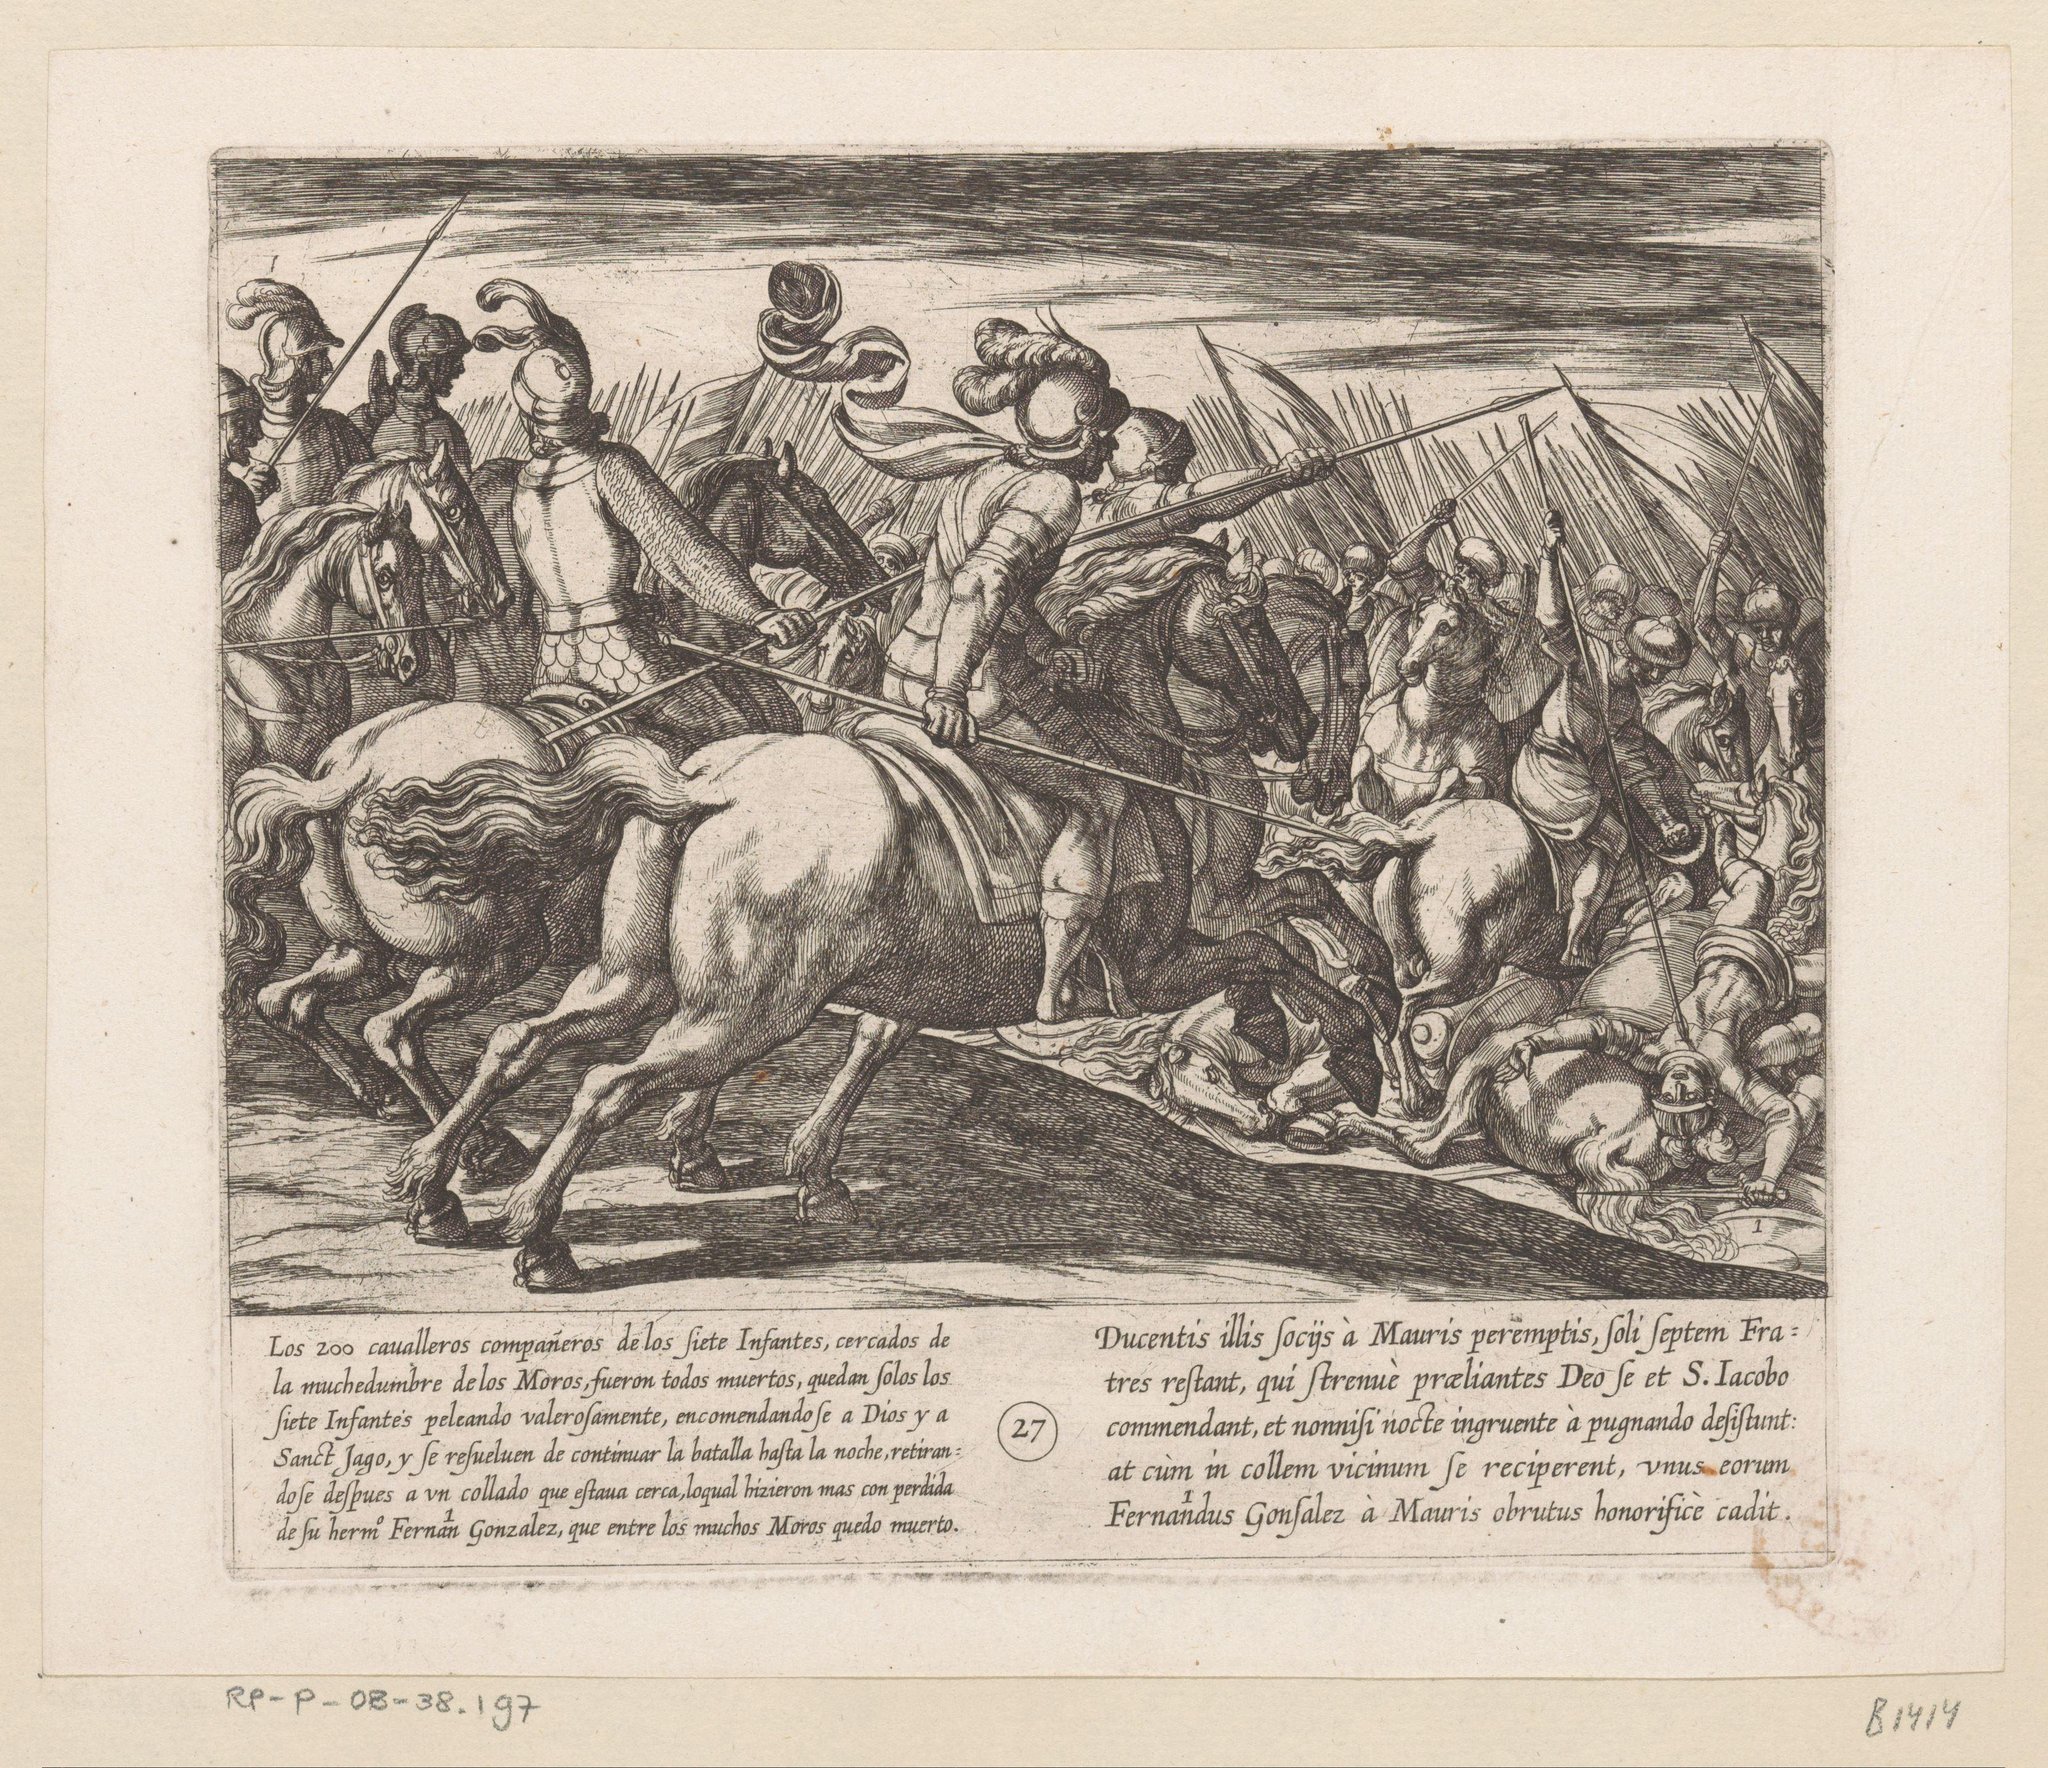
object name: print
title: Historia Septem Infantium de Lara/ Historia de los Siete Infantes de Lara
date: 1612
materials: paper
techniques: etching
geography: antwerp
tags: battle, warfare; military affairs (+ cavalry, horsemen), tales and fairy tales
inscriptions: collector's mark: Lugt 240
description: Deze prent maakt deel uit van een reeks van 40 prenten (+ titelprent) met voorstellingen uit het volksverhaal over de zeven infanten van Lara.